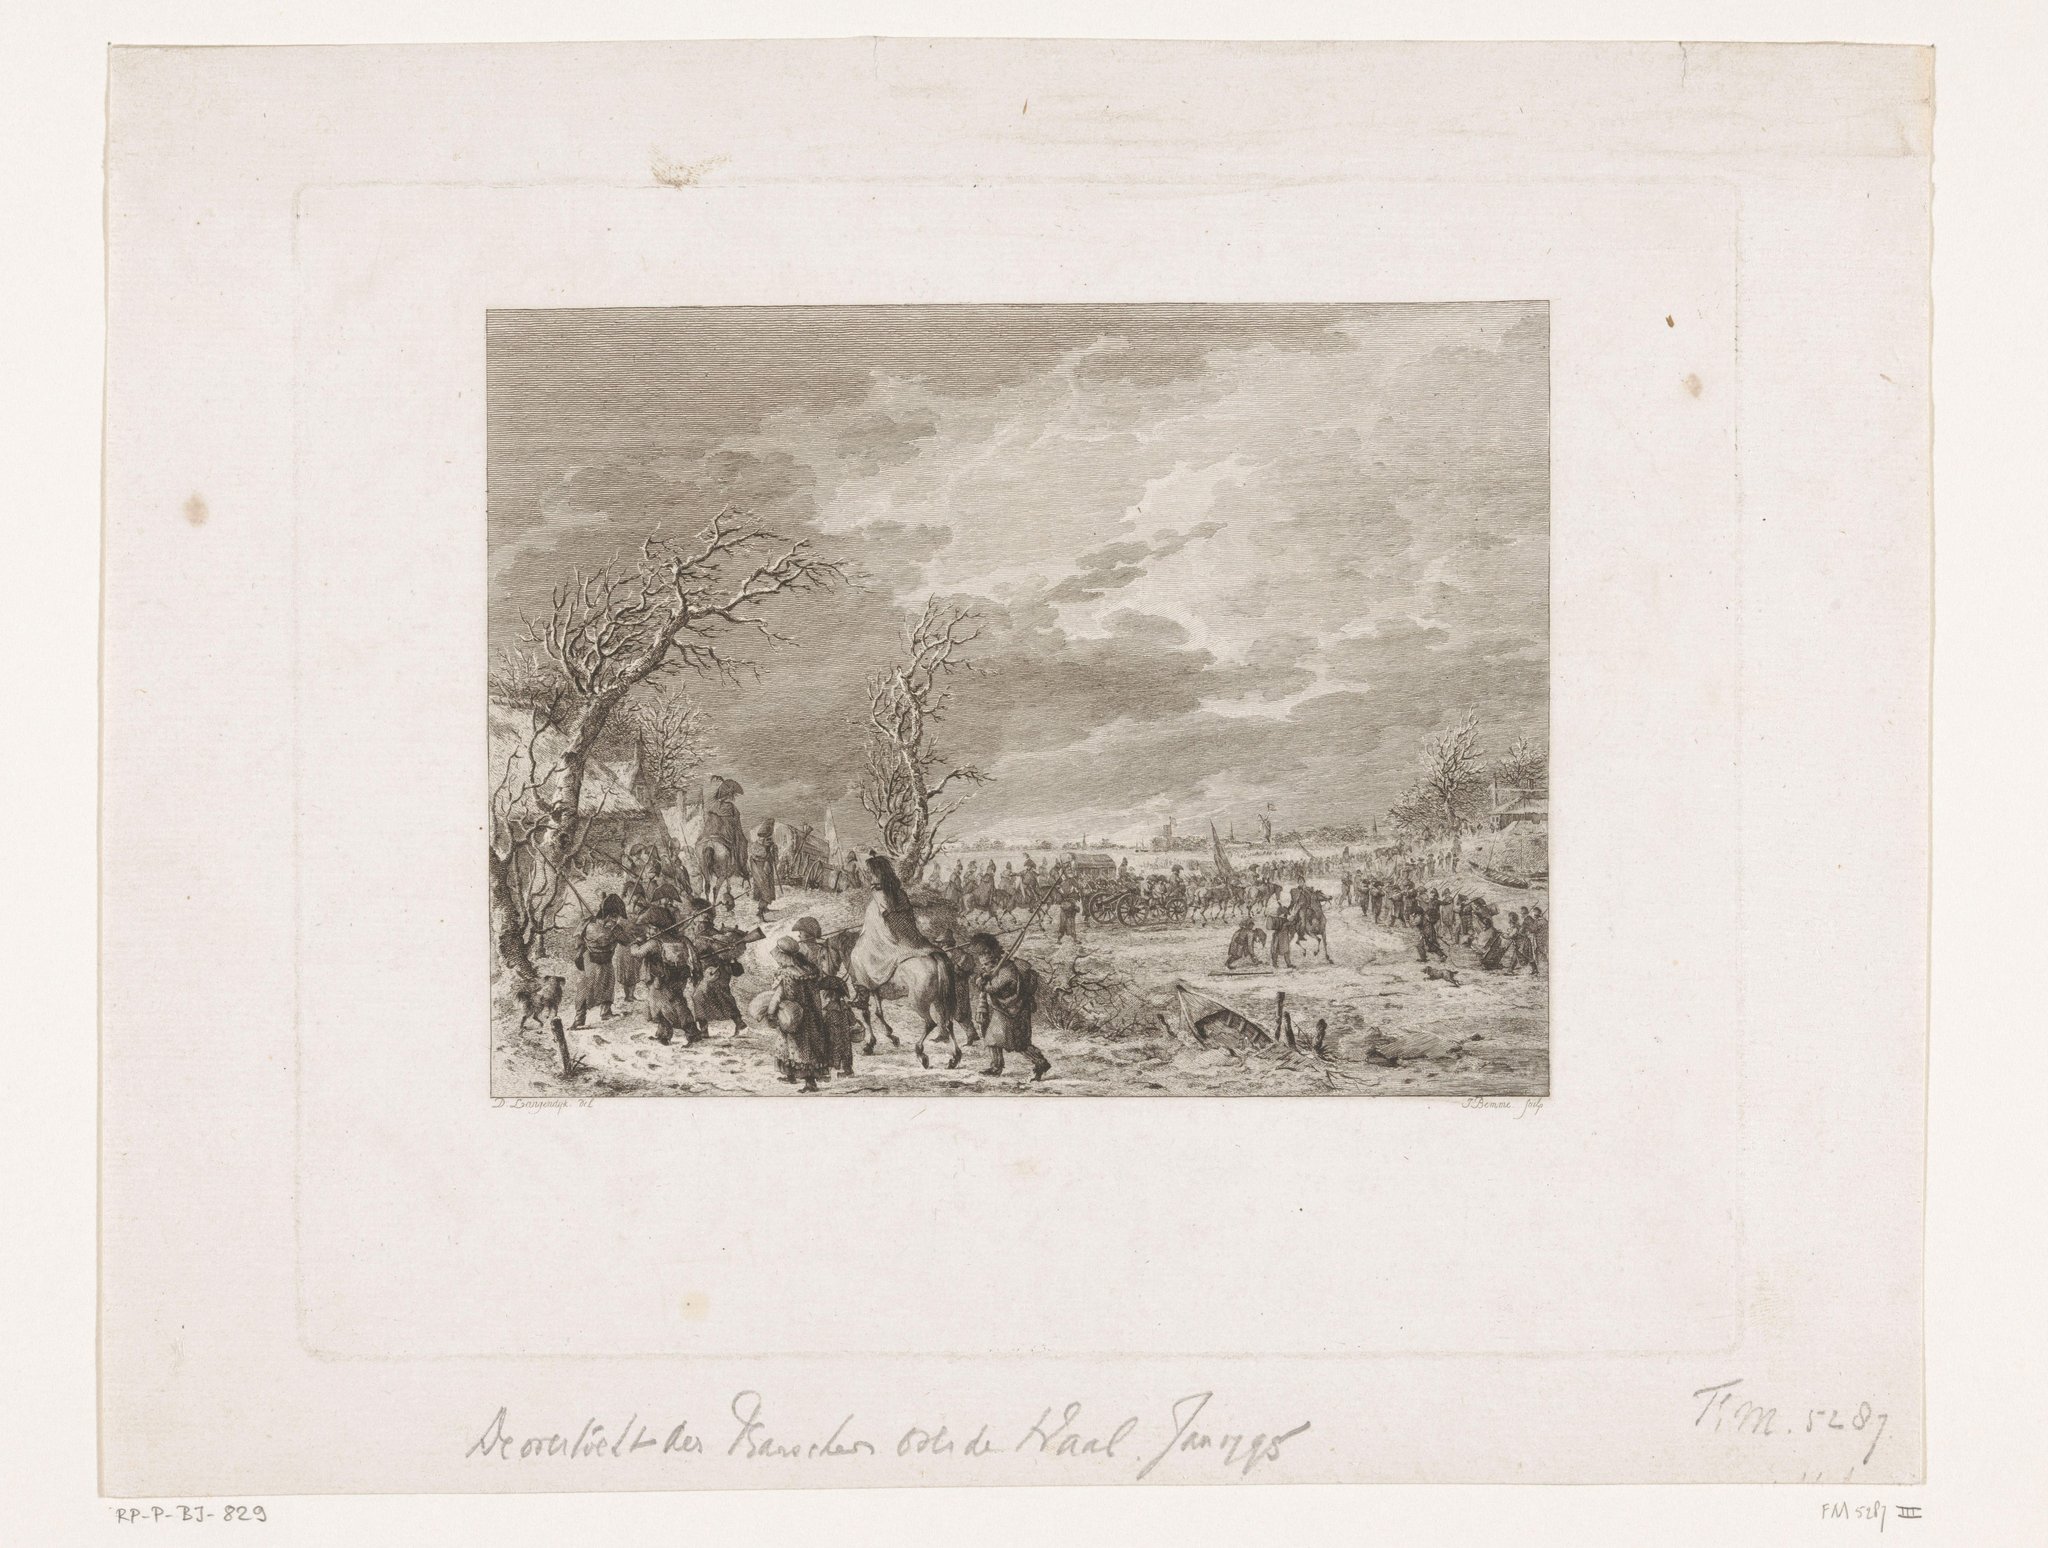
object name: print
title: Overtocht van de Franse troepen over de Waal in januari 1795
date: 1795-1841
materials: paper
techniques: etching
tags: the defeated (after the battle)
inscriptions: collector's mark: Lugt 2228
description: De gehavende soldaten steken te voet en te paard de bevroren rivier over. Geschut wordt op wagens mee gevoerd.